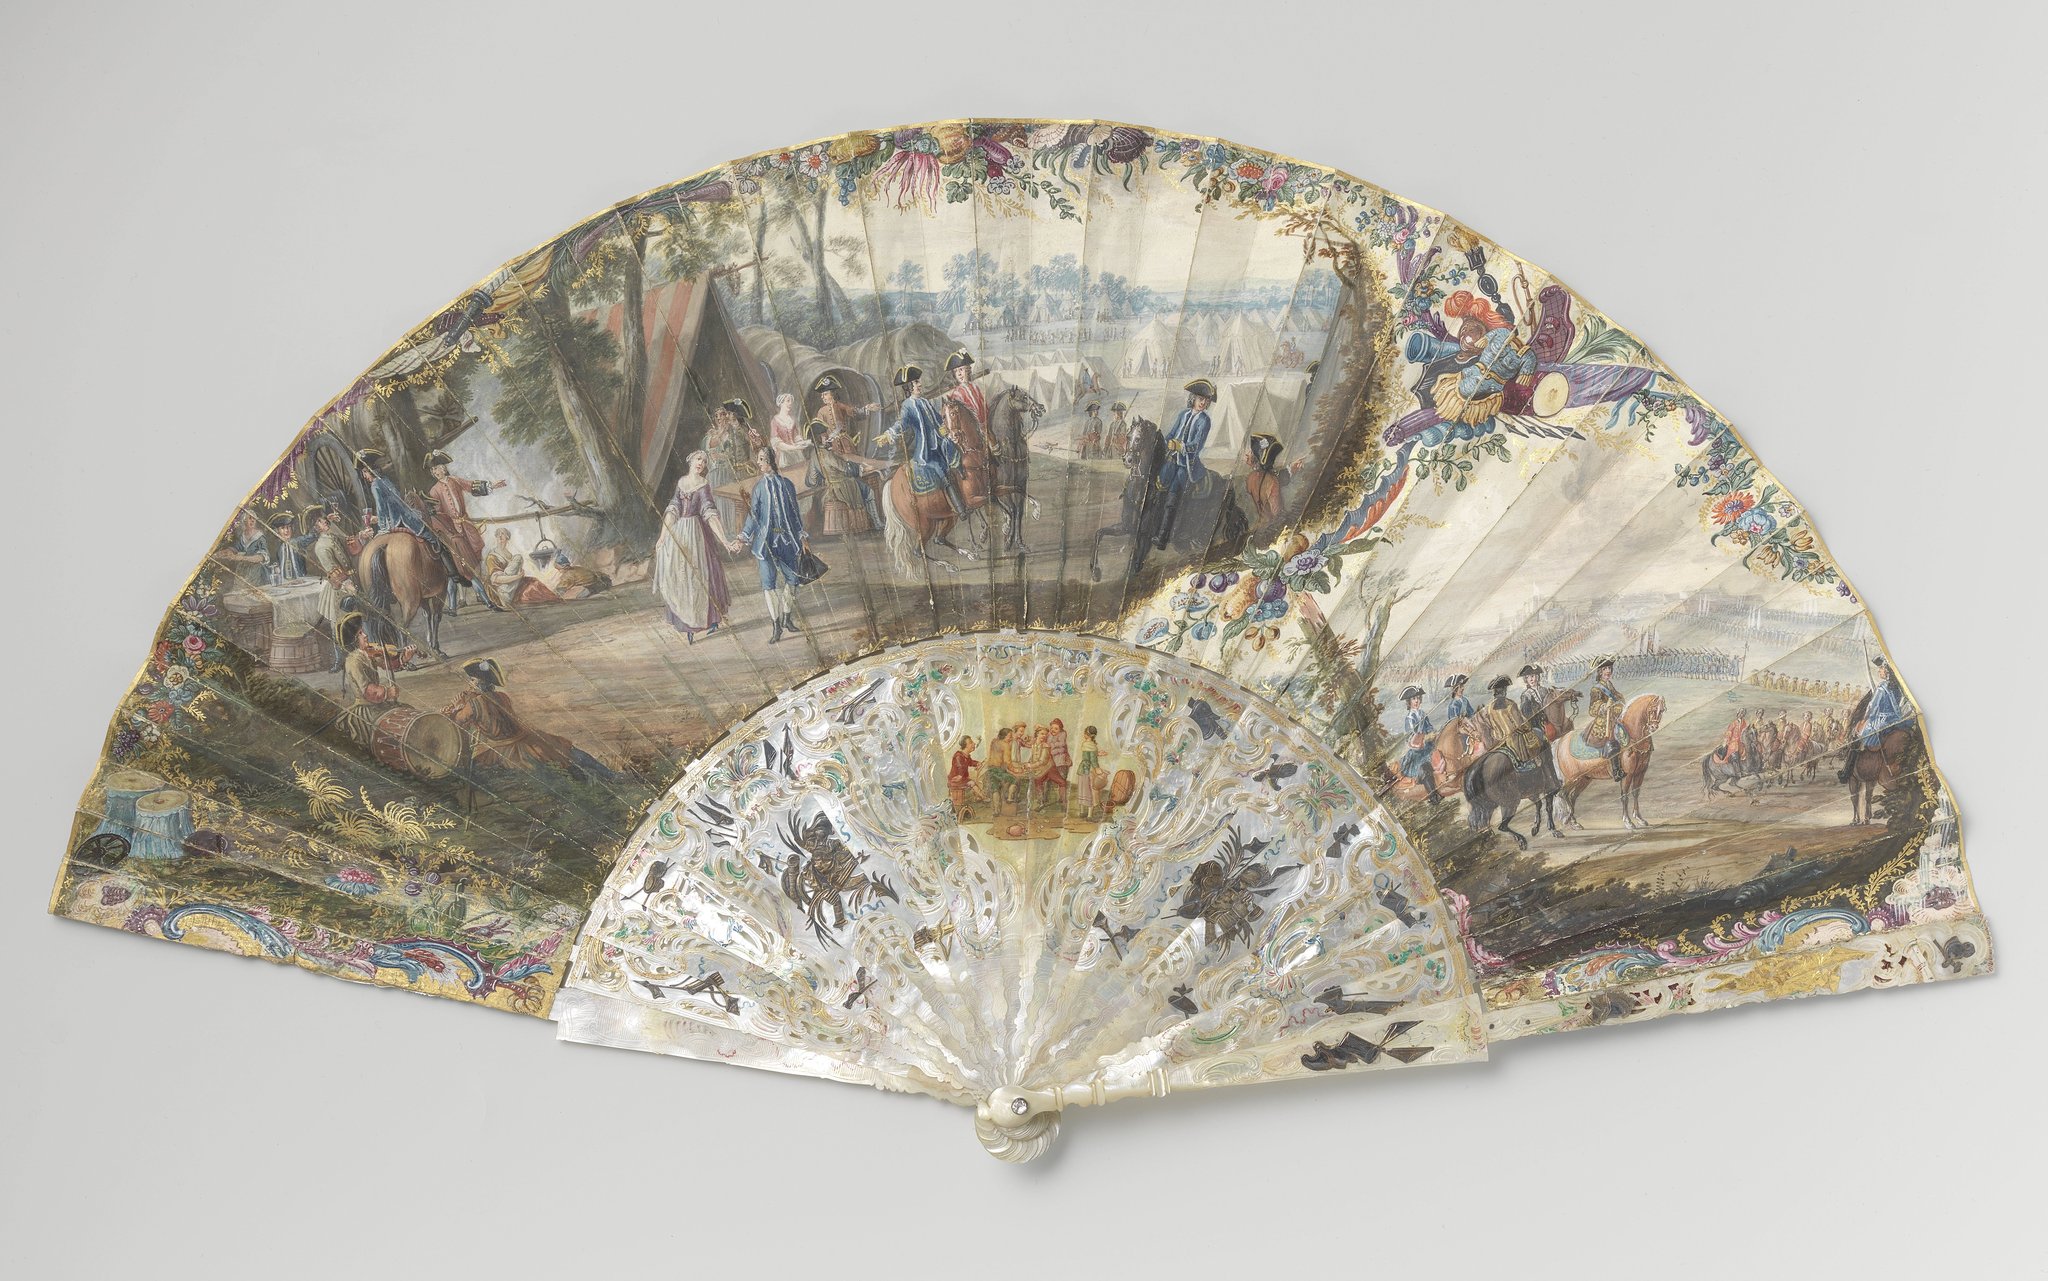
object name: vouwwaaier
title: Vouwwaaier met een dubbel blad van papier waarop in gouache aan de voorkant een militair kampement en een legerformatie, op de achterkant het beleg van een stad, op een ajour en in reliëf gesneden montuur van parelmoer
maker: Anonymous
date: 1750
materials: glass, gouache, mother of pearl, oil, paint, paper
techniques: cutting, grinding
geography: france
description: Deze waaier staat geheel in het teken van het krijgsbedrijf. Het is een goed voorbeeld van een eenheid in blad en montuur. Het blad heeft aan de voorkant een niet veel voorkomende, asymmetrische verdeling met links een Frans legerkamp en rechts een maarschalk die samen met hoge, Franse officieren te paard een parade afneemt. In de linker cartouche: de militairen in grijze uniformen met tricorns getooid met witte cocarde's zijn franse troepen tussen 1734 en 1757. Vanaf 1762 zijn de cocarde's zwart. Waarschijnlijk is hier een groep 'anspessades' te zien; edellieden, elite soldaten, die dienden bij de infanterie:12 op een compagnie van 300 man. In de rechter cartouche: de caveleristen in blauwe justaucorps (met rode mouwopslagen) zijn hoogstwaarschijnlijk Gardes du Corps, Maison du Roi. De cavaleristen in rode jassen zijn Gendarmes de la Garde of Chevaux-legers de la Garde of Mousquetaires. De middelste figuur - met in de rechterhand een maarschalkstaf - draagt over de linkerschouder het blauwe ordelint van de 'Ordre du Saint Esprit'. Mogelijk is hier Lodewijk XV (1710-1715-1774) afgebeeld. Deze koning voerde tussen 1740-8 de 'Oostenrijkse Successieoorlog in verband met de opvolging van Maria Theresia in de Oostenrijkse erflanden. De Fransen onder aanvoering van Maurits van Saksen versloegen de verboden Engelsen, Hollanders en Oostenrijkers in de slag bij Fontenay (Henegouwen) op 11 mei 1746 en bij Lafeld (juli 1747). De troepen op de achtergrond zijn franse regimenten, zie de witte franse koninklijke vlaggen. Op een der linies is een militair met een 'sponton' (officier) of een hellebaard (onderofficier) te zien. Bijzonder opvallend is de samengestelde, ornamentele rand om de voorstellingen. Behalve de militaire attributen die men op een dergelijke waaier zou verwachten zijn prominent in het midden verschillende groenten, waaronder radijs, aubergine, pompoen en bonen, afgebeeld tesamen met vruchten en schelpen. Tenslotte valt de kleine cascade in de hoek op. Aan de achterzijde zijn over de uiteinden van de benen extra stroken papier geplakt, zodat het blad over de gehele breedte beschilderd kon worden. Het uit rocailles opgebouwde montuur is bijzonder rijk in reliëf gesneden met allerlei militaire attributen. In de centrale reserve een boertige scène in de trant van de Vlaamse schilder David Teniers de jongere (1610-1690) wier werk in de 18e eeuw in Frankrijk bijzonder geliefd was en vele malen in grafiek werd uitgegeven. Op het montuur een trofee met geschut en roedebundel